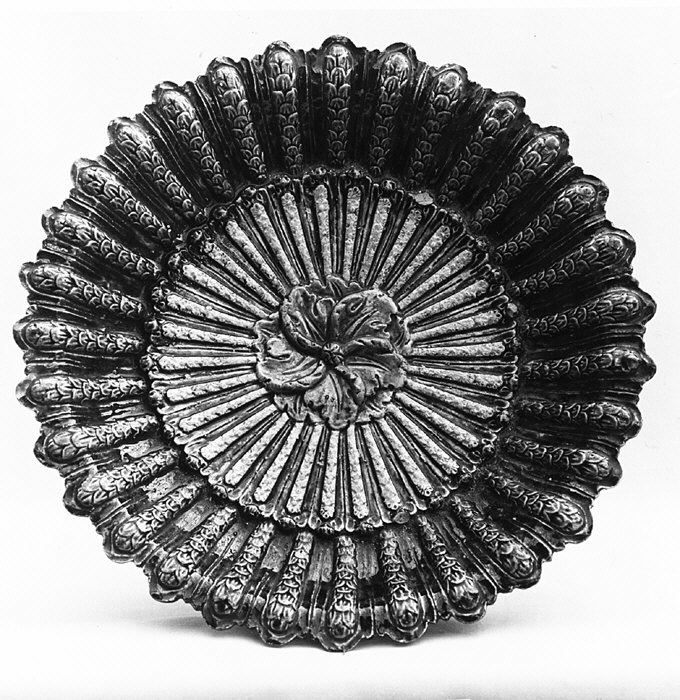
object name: dish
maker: bernard palissy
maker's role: maker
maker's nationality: french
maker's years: 1510-1590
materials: earthenware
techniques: glazing